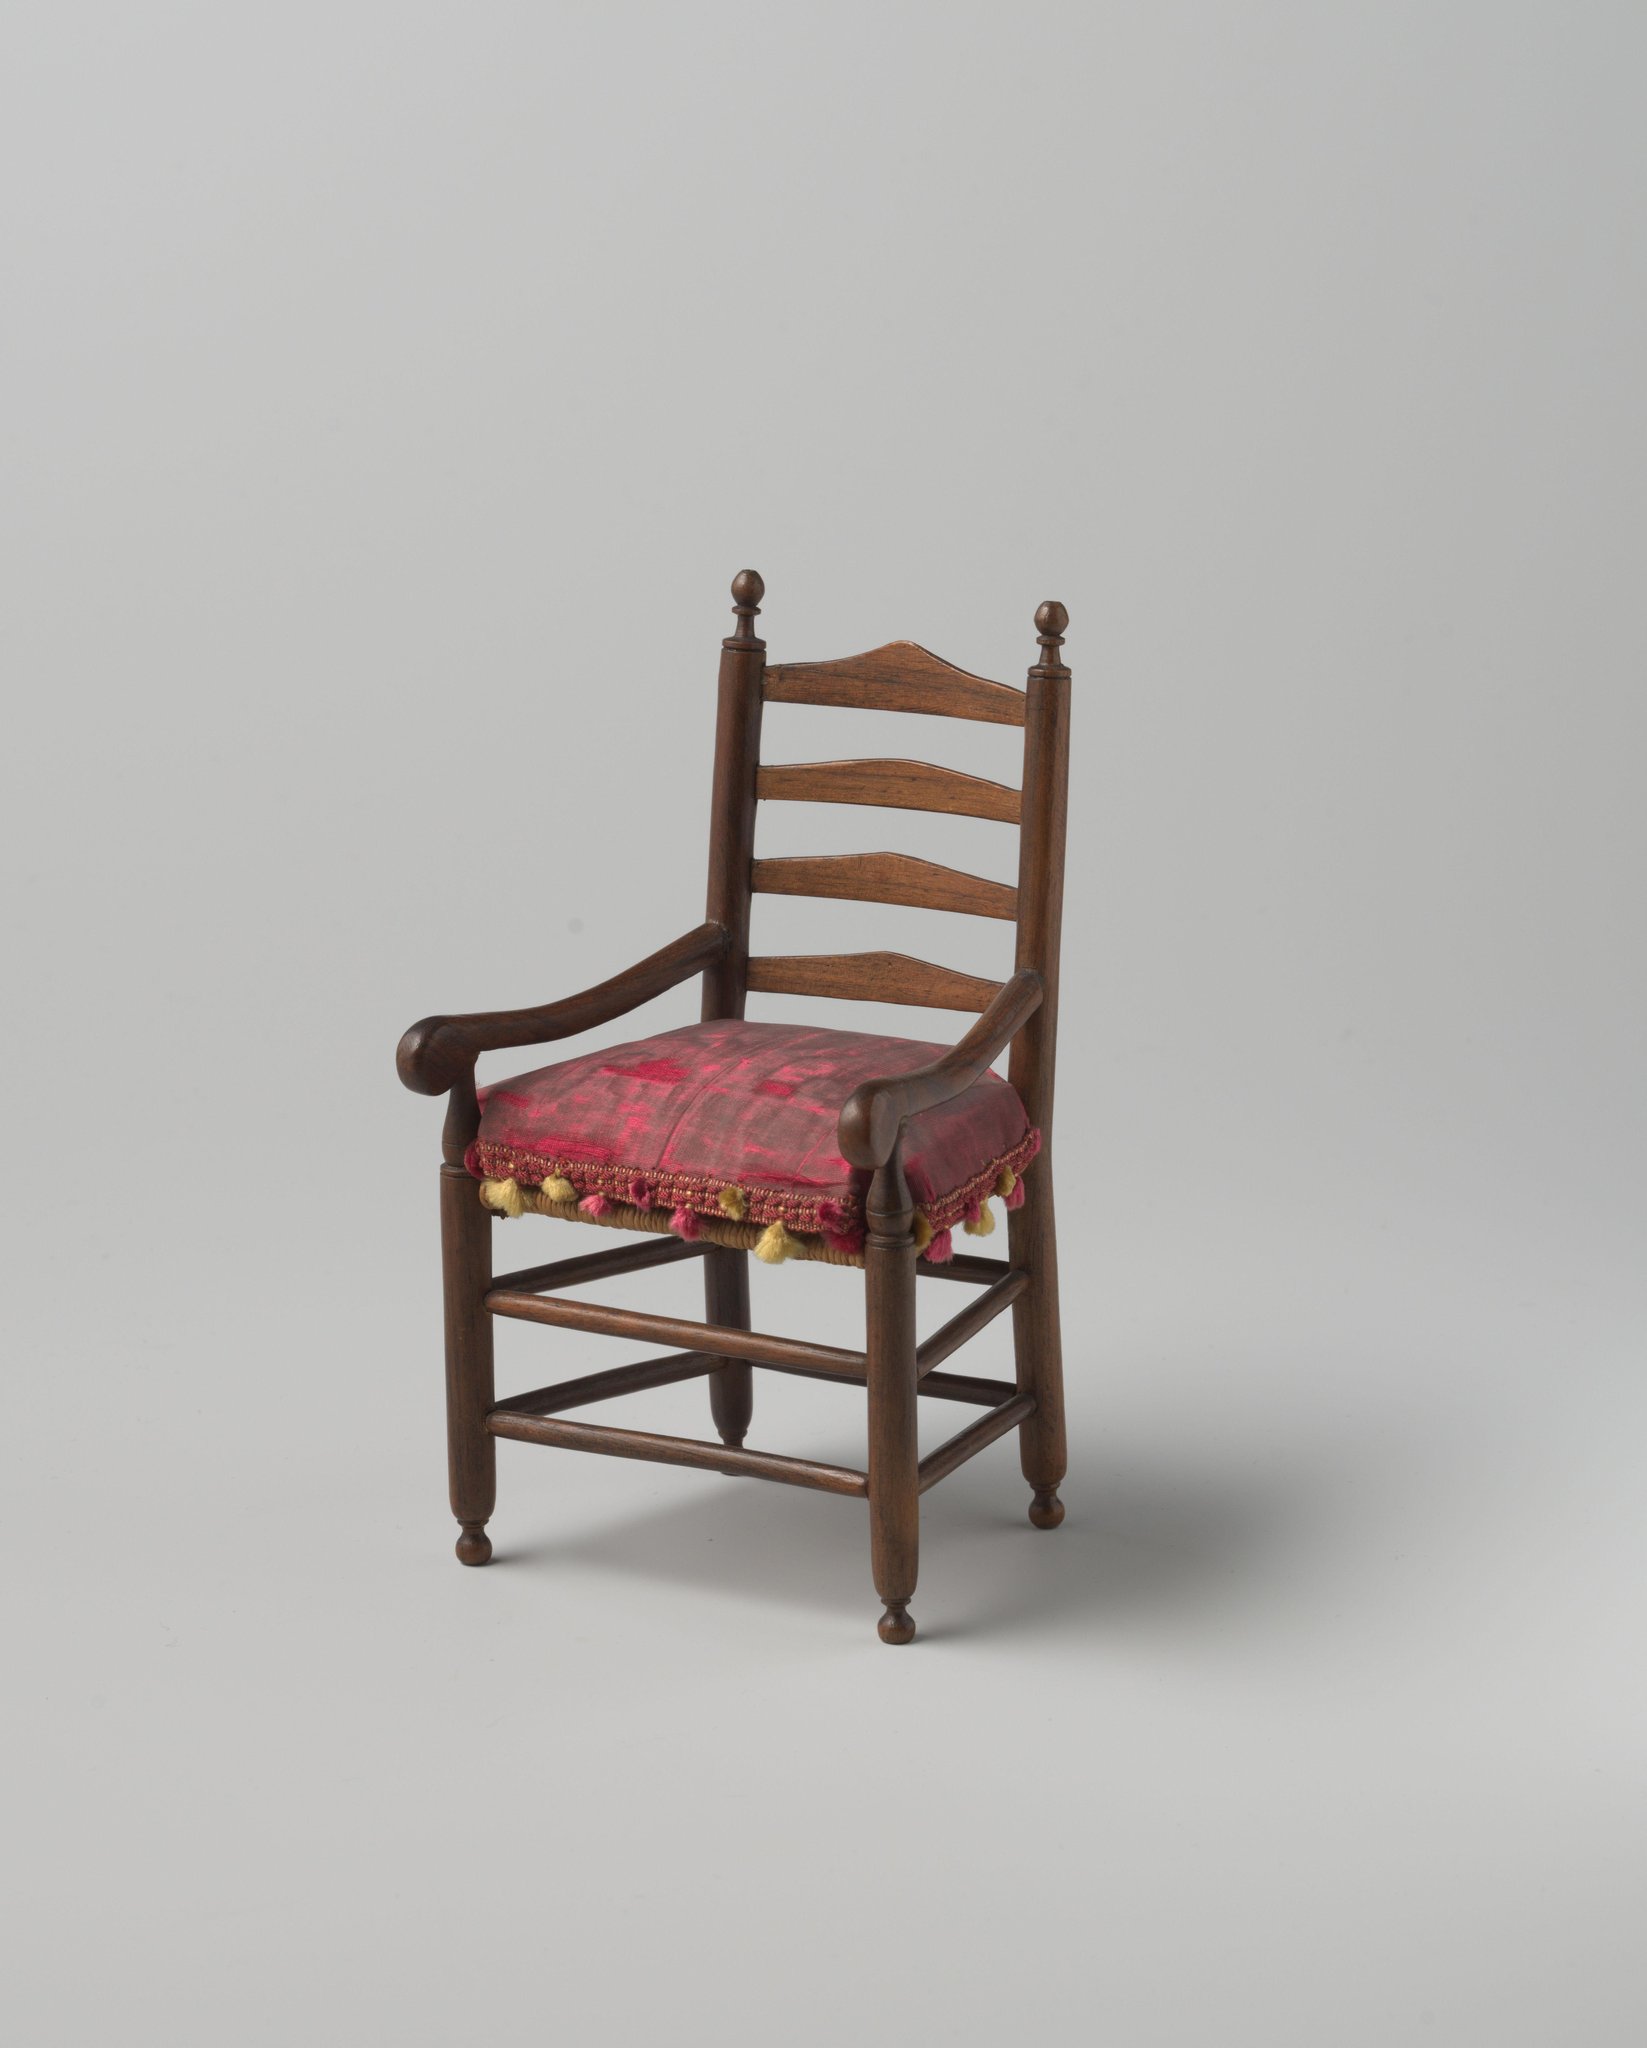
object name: knopstoel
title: Armstoel (model knopstoel) van notenhout met gladde, gedraaide stijlen en dwarsregels, voorpoten en achterstijlen eindigend in fijn gedraaide knoppen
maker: Anonymous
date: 1690-1710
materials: cardboard, linen, silk, fiber, wood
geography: amsterdam